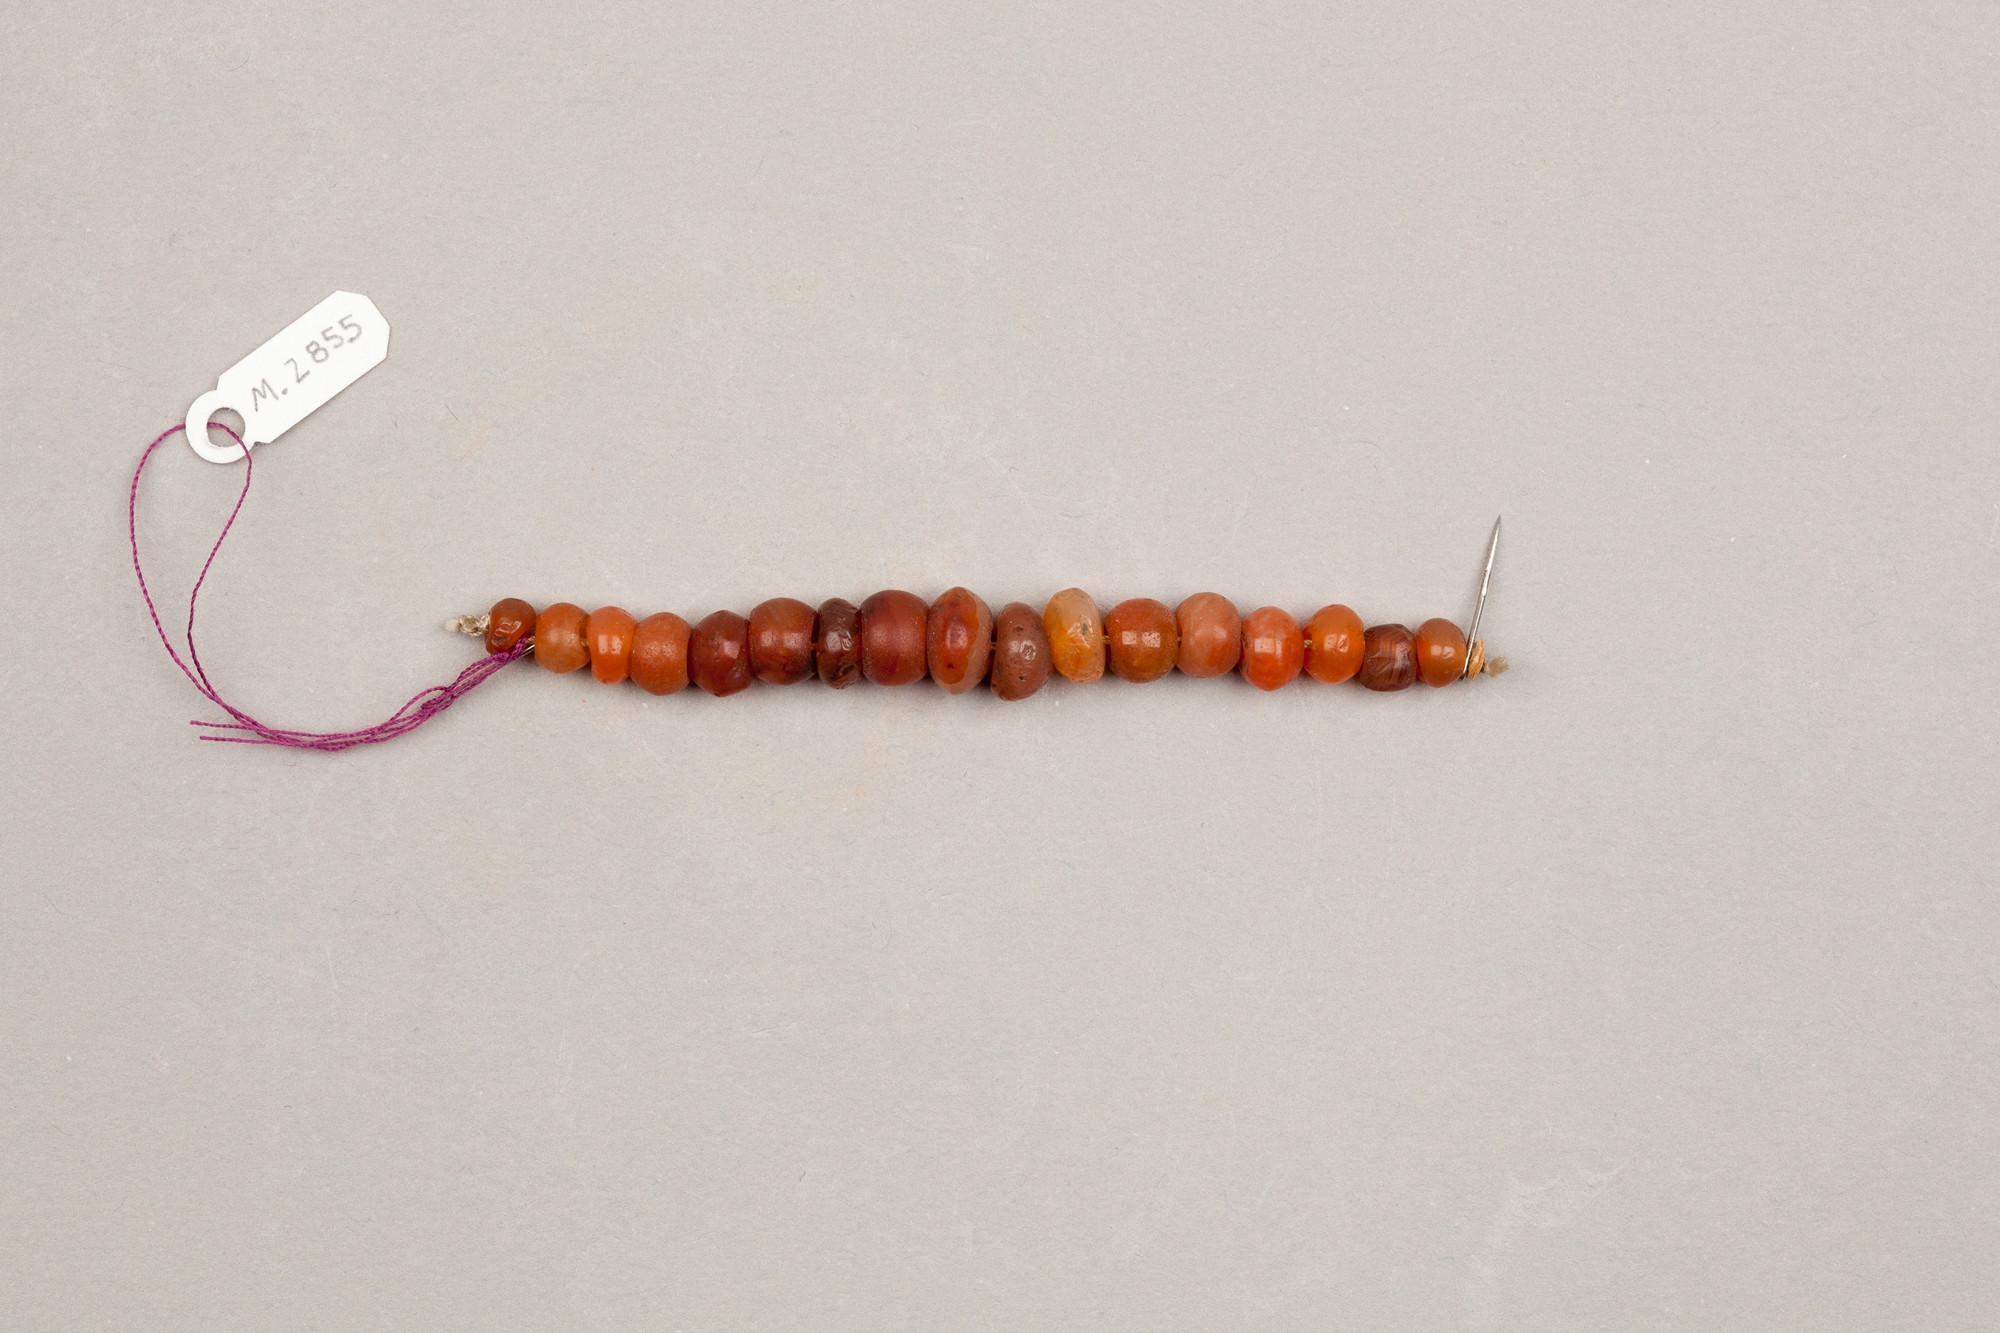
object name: bead, string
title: String of beads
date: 3850-2960 BCE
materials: gemstone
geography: egypt